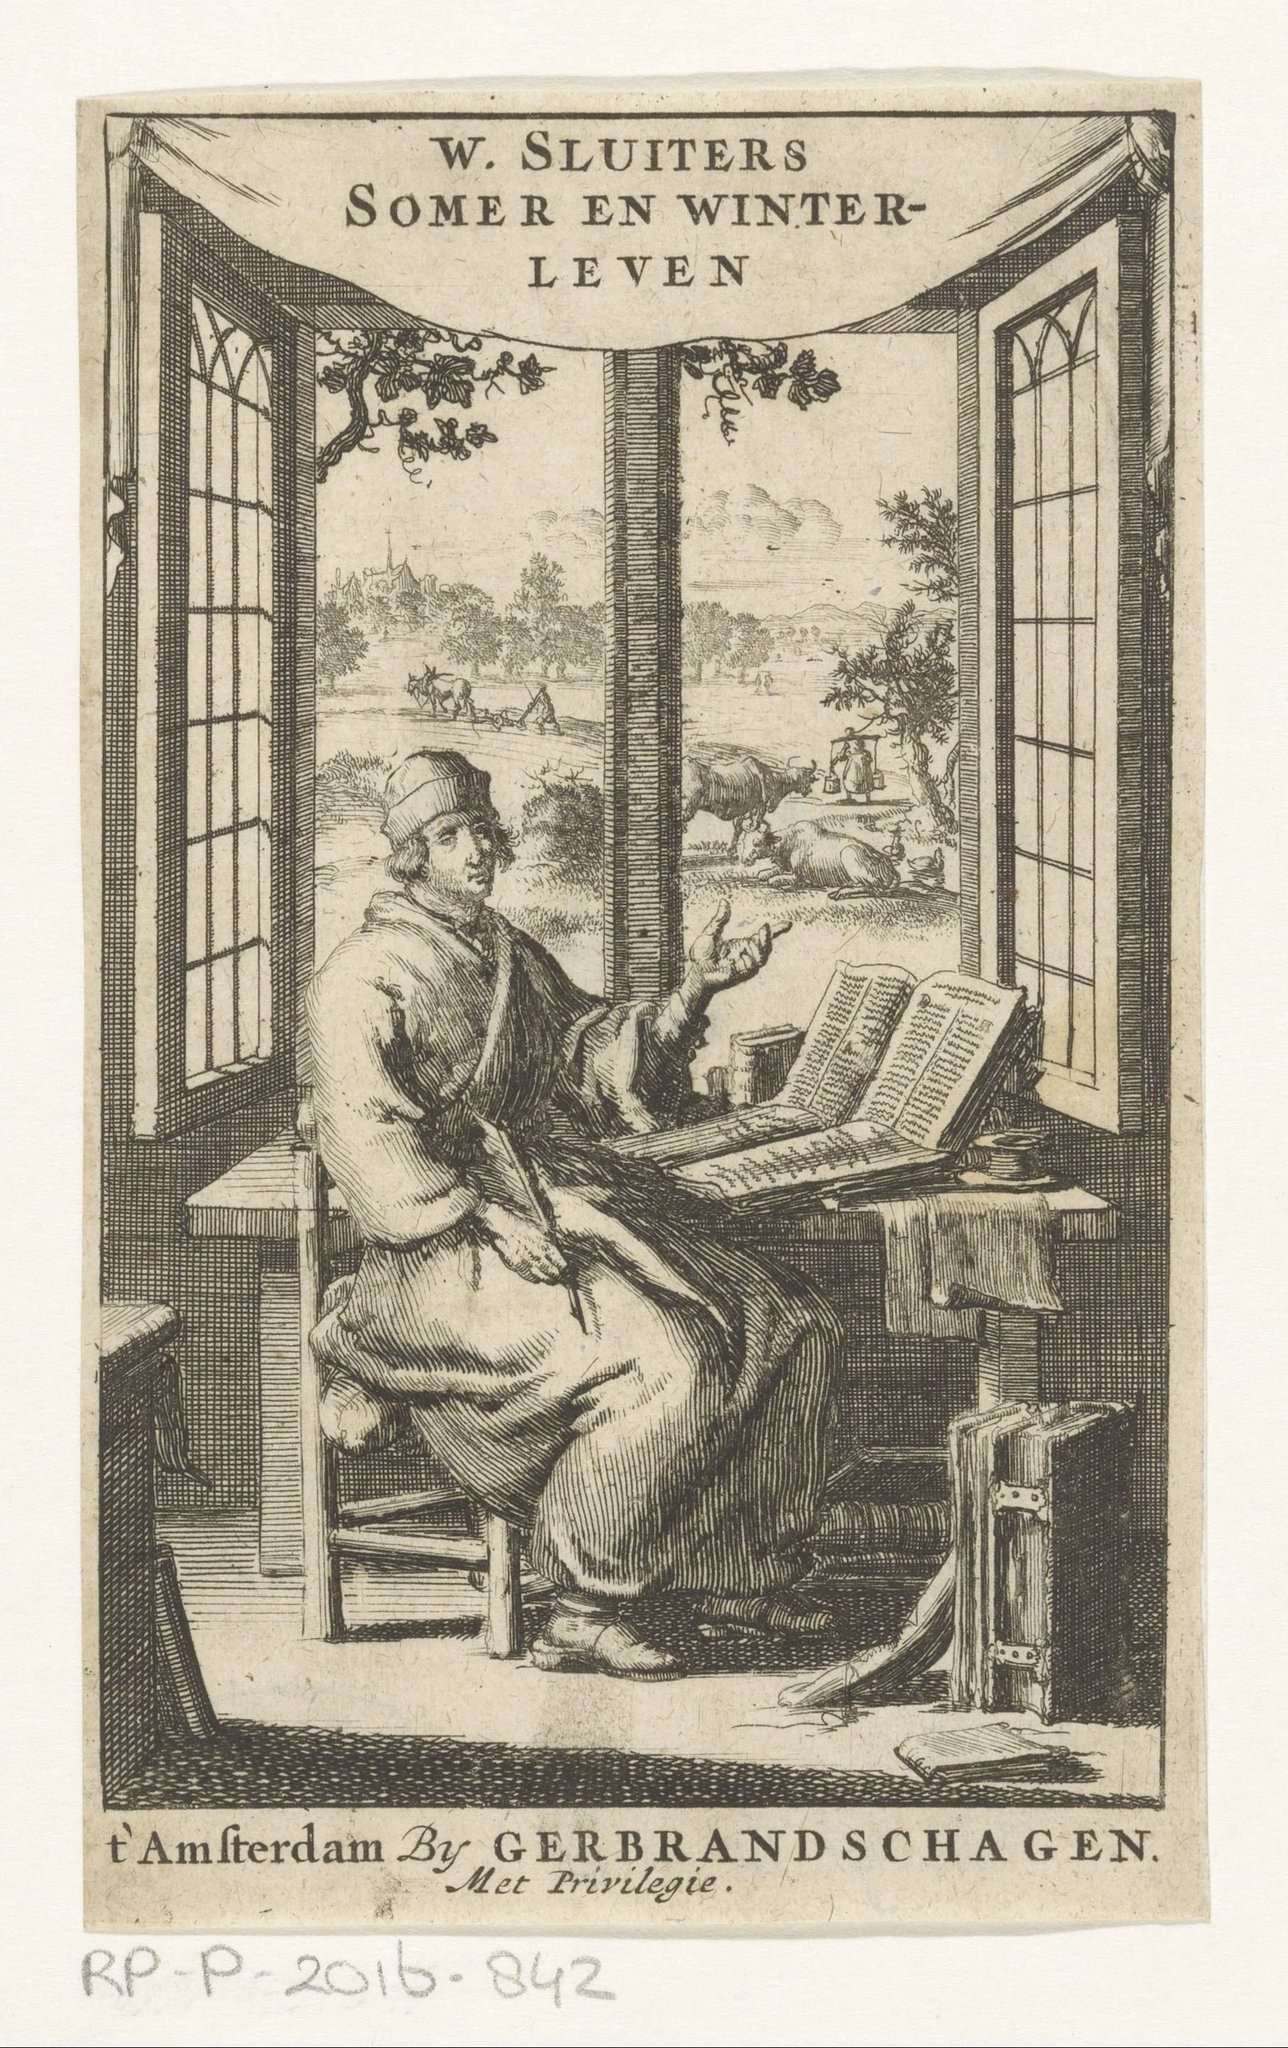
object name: print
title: Schrijver aan bureau bij geopend venster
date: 1687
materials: paper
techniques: etching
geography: amsterdam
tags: human figure at (open) window, author, poet writing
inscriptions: collector's mark: Lugt 2228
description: Titelpagina voor: Sluiter, Willem. Buiten- eensaem huis- somer- en winter-leven. Amsterdam: Schagen, Gerbrandt, 1687. Prent afkomstig uit een plakalbum met titelprenten, ornamenten etc. op blauw papier in 1983 uit elkaar gehaald. Volgens een notitie op verso zat de prent op p. 118 van dit album.